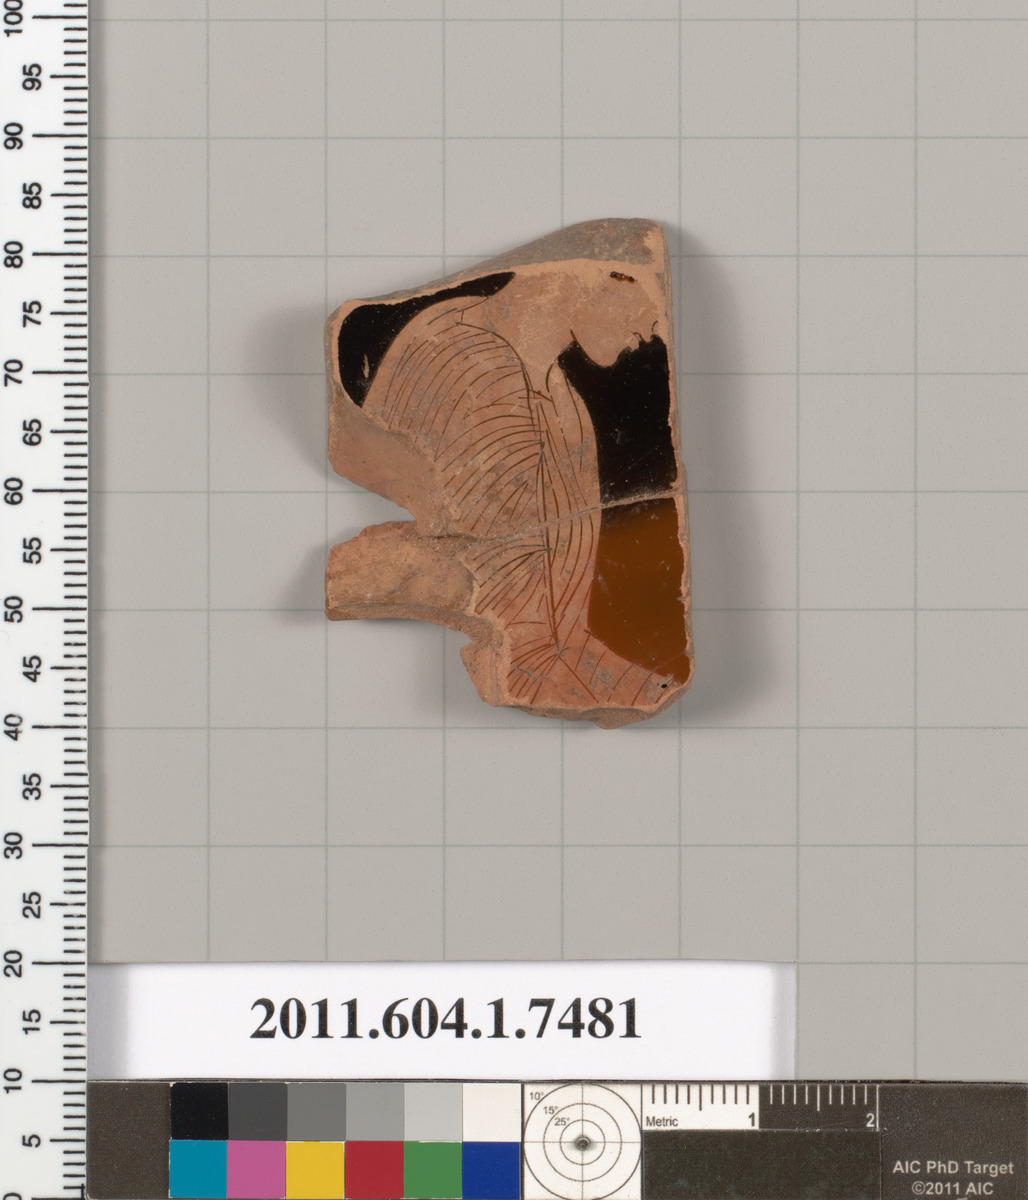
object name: kylix fragment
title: Terracotta fragment of a kylix (drinking cup)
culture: greek, attic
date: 460-450 BCE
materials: terracotta